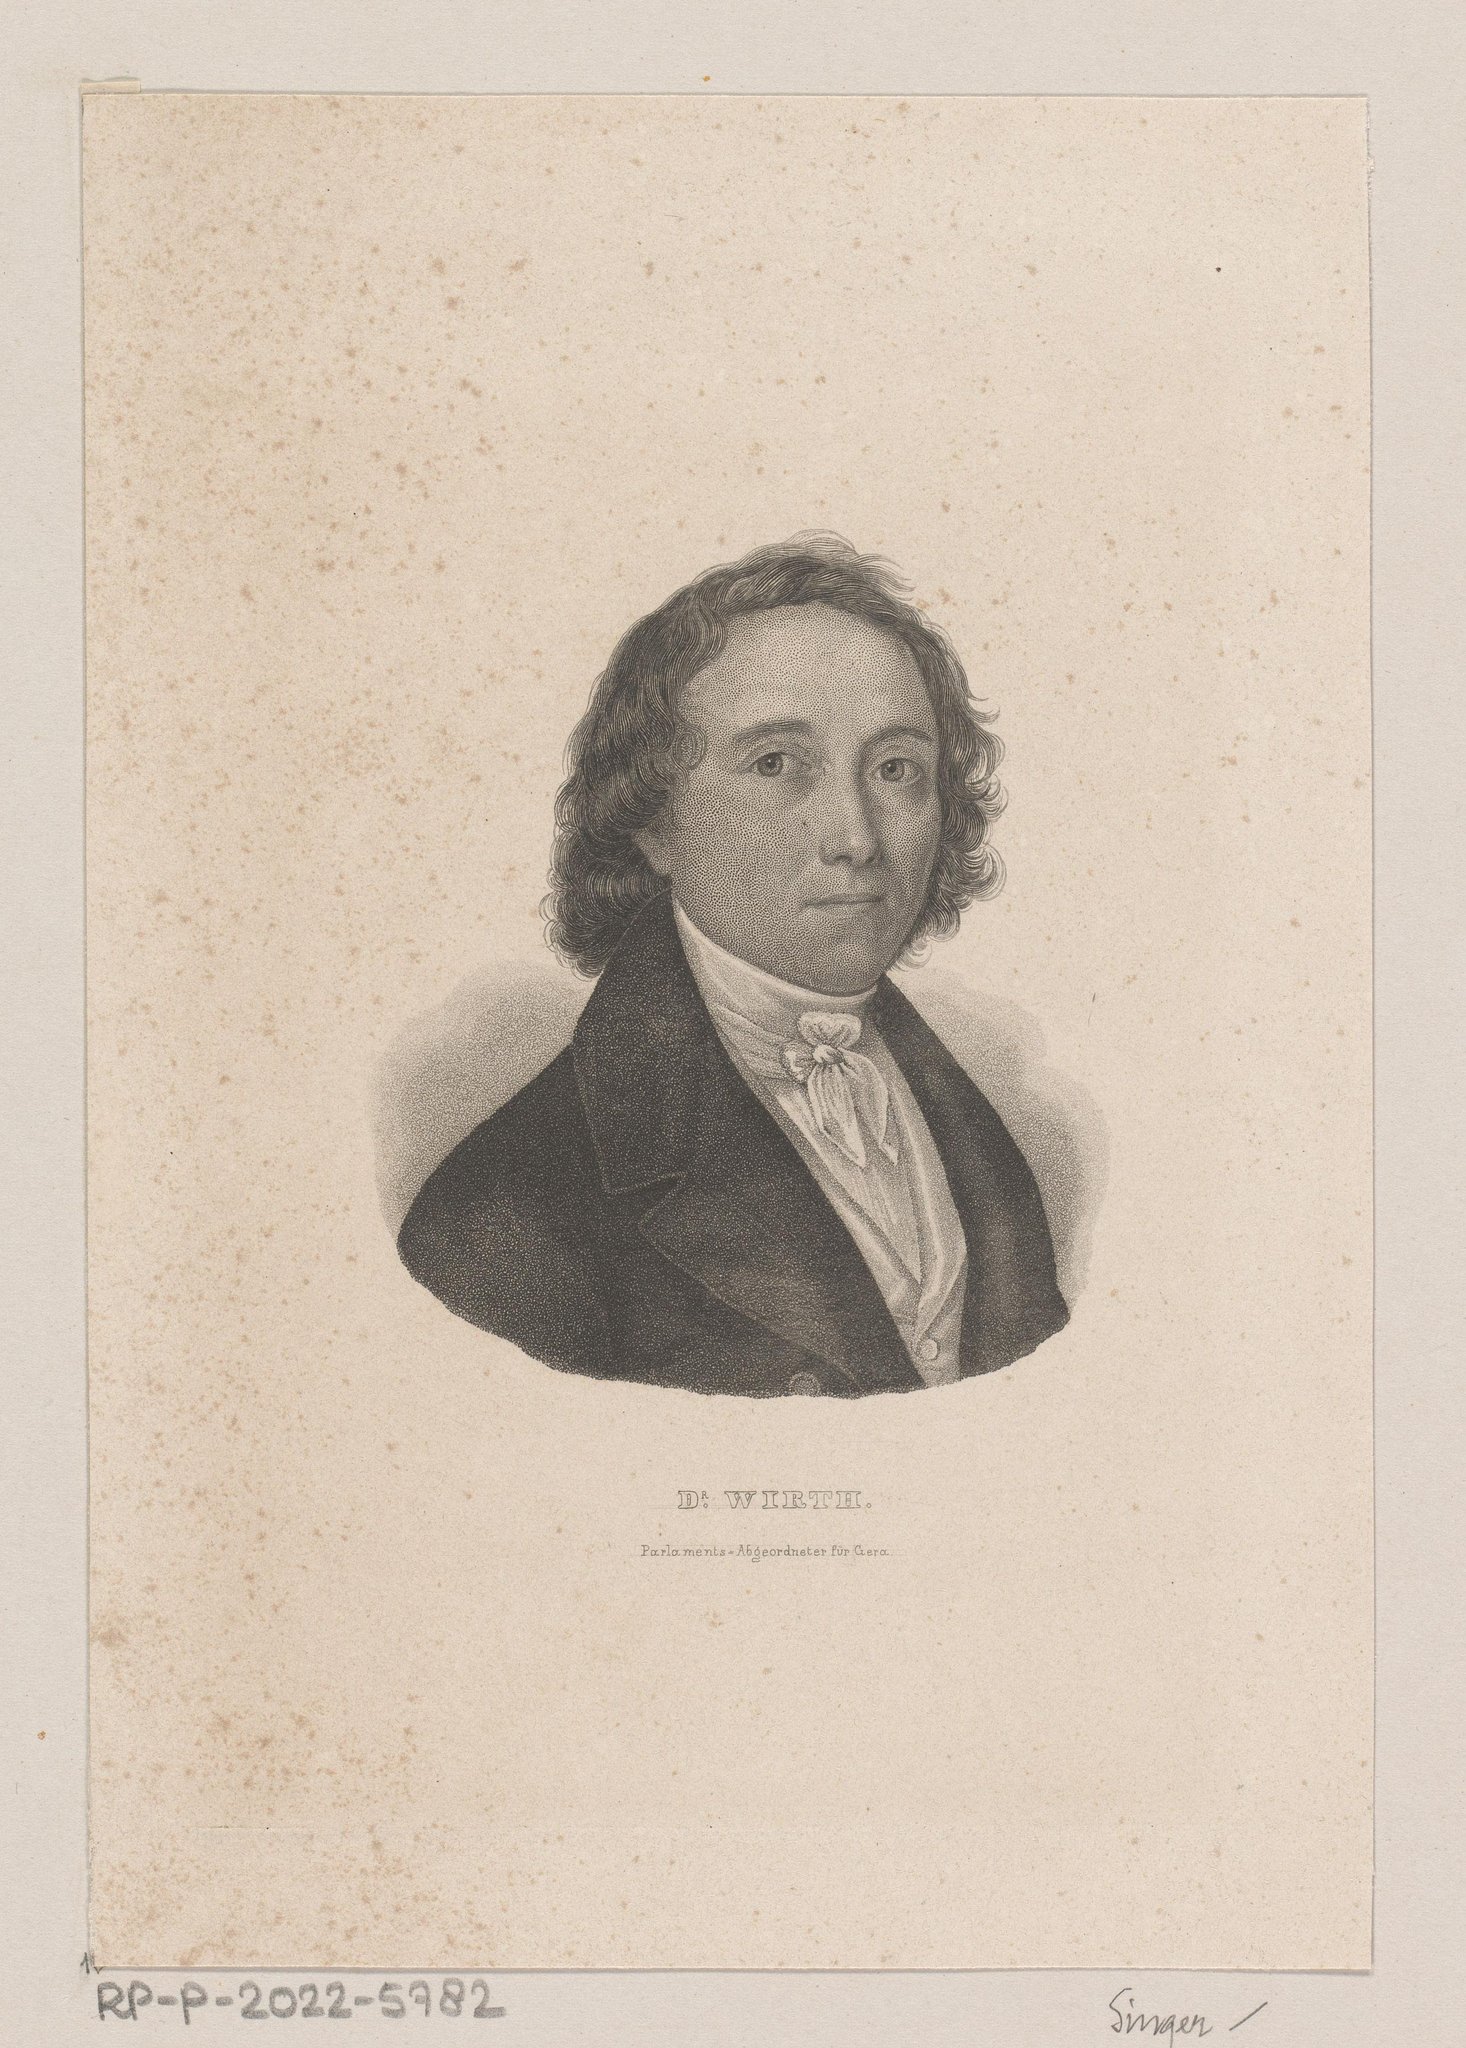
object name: book illustration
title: Portret van Johann Georg August Wirth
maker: Anonymous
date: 1851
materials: paper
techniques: aquatint, etching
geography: germany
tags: politician, journalist, reporter, historical persons, portrait of a writer, politician, e.g. party leader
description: Prent waarschijnlijk uit: Zimmermann, Wilhelm. Die deutsche Revolution. Karlsruhe: Kunstverlag, 1851.